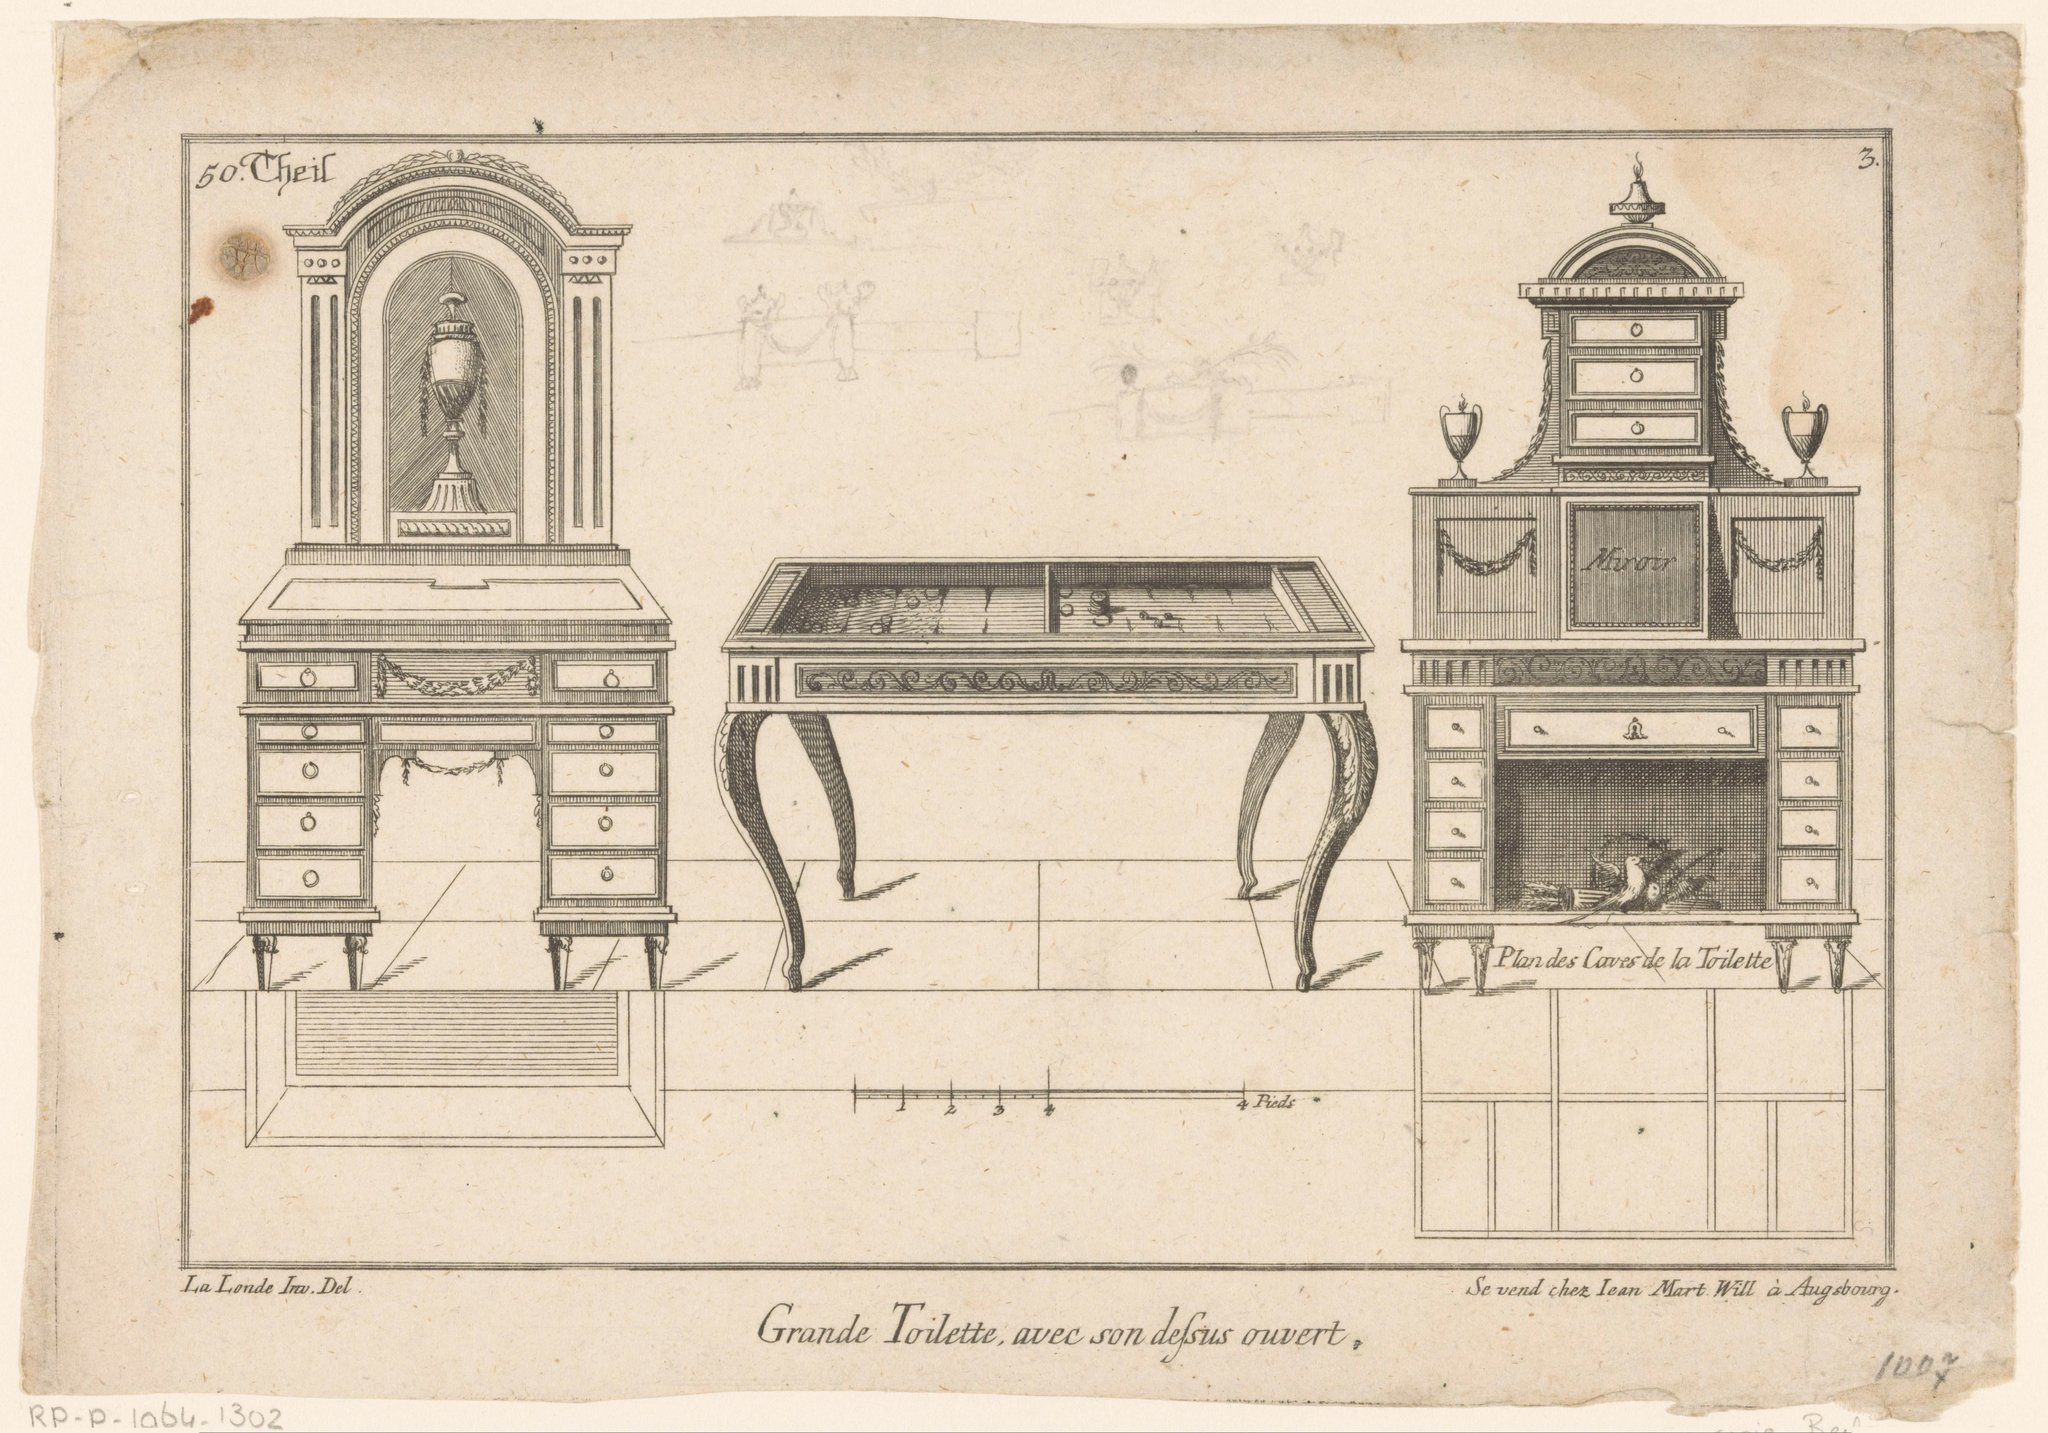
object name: print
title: Grande Toilette, avec sons dessus ouvert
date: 1784-1806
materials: paper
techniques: engraving, etching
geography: augsburg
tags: making toilet, table, board-games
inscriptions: collector's mark: Lugt 2760, collector's mark: Lugt 2228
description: Links een toilettafel met lades en een halfronde overkapping. In het midden een speeltafel met trictracbord aan de binnenzijde. Rechts een toilettafel met lades, een spiegel en vazen.